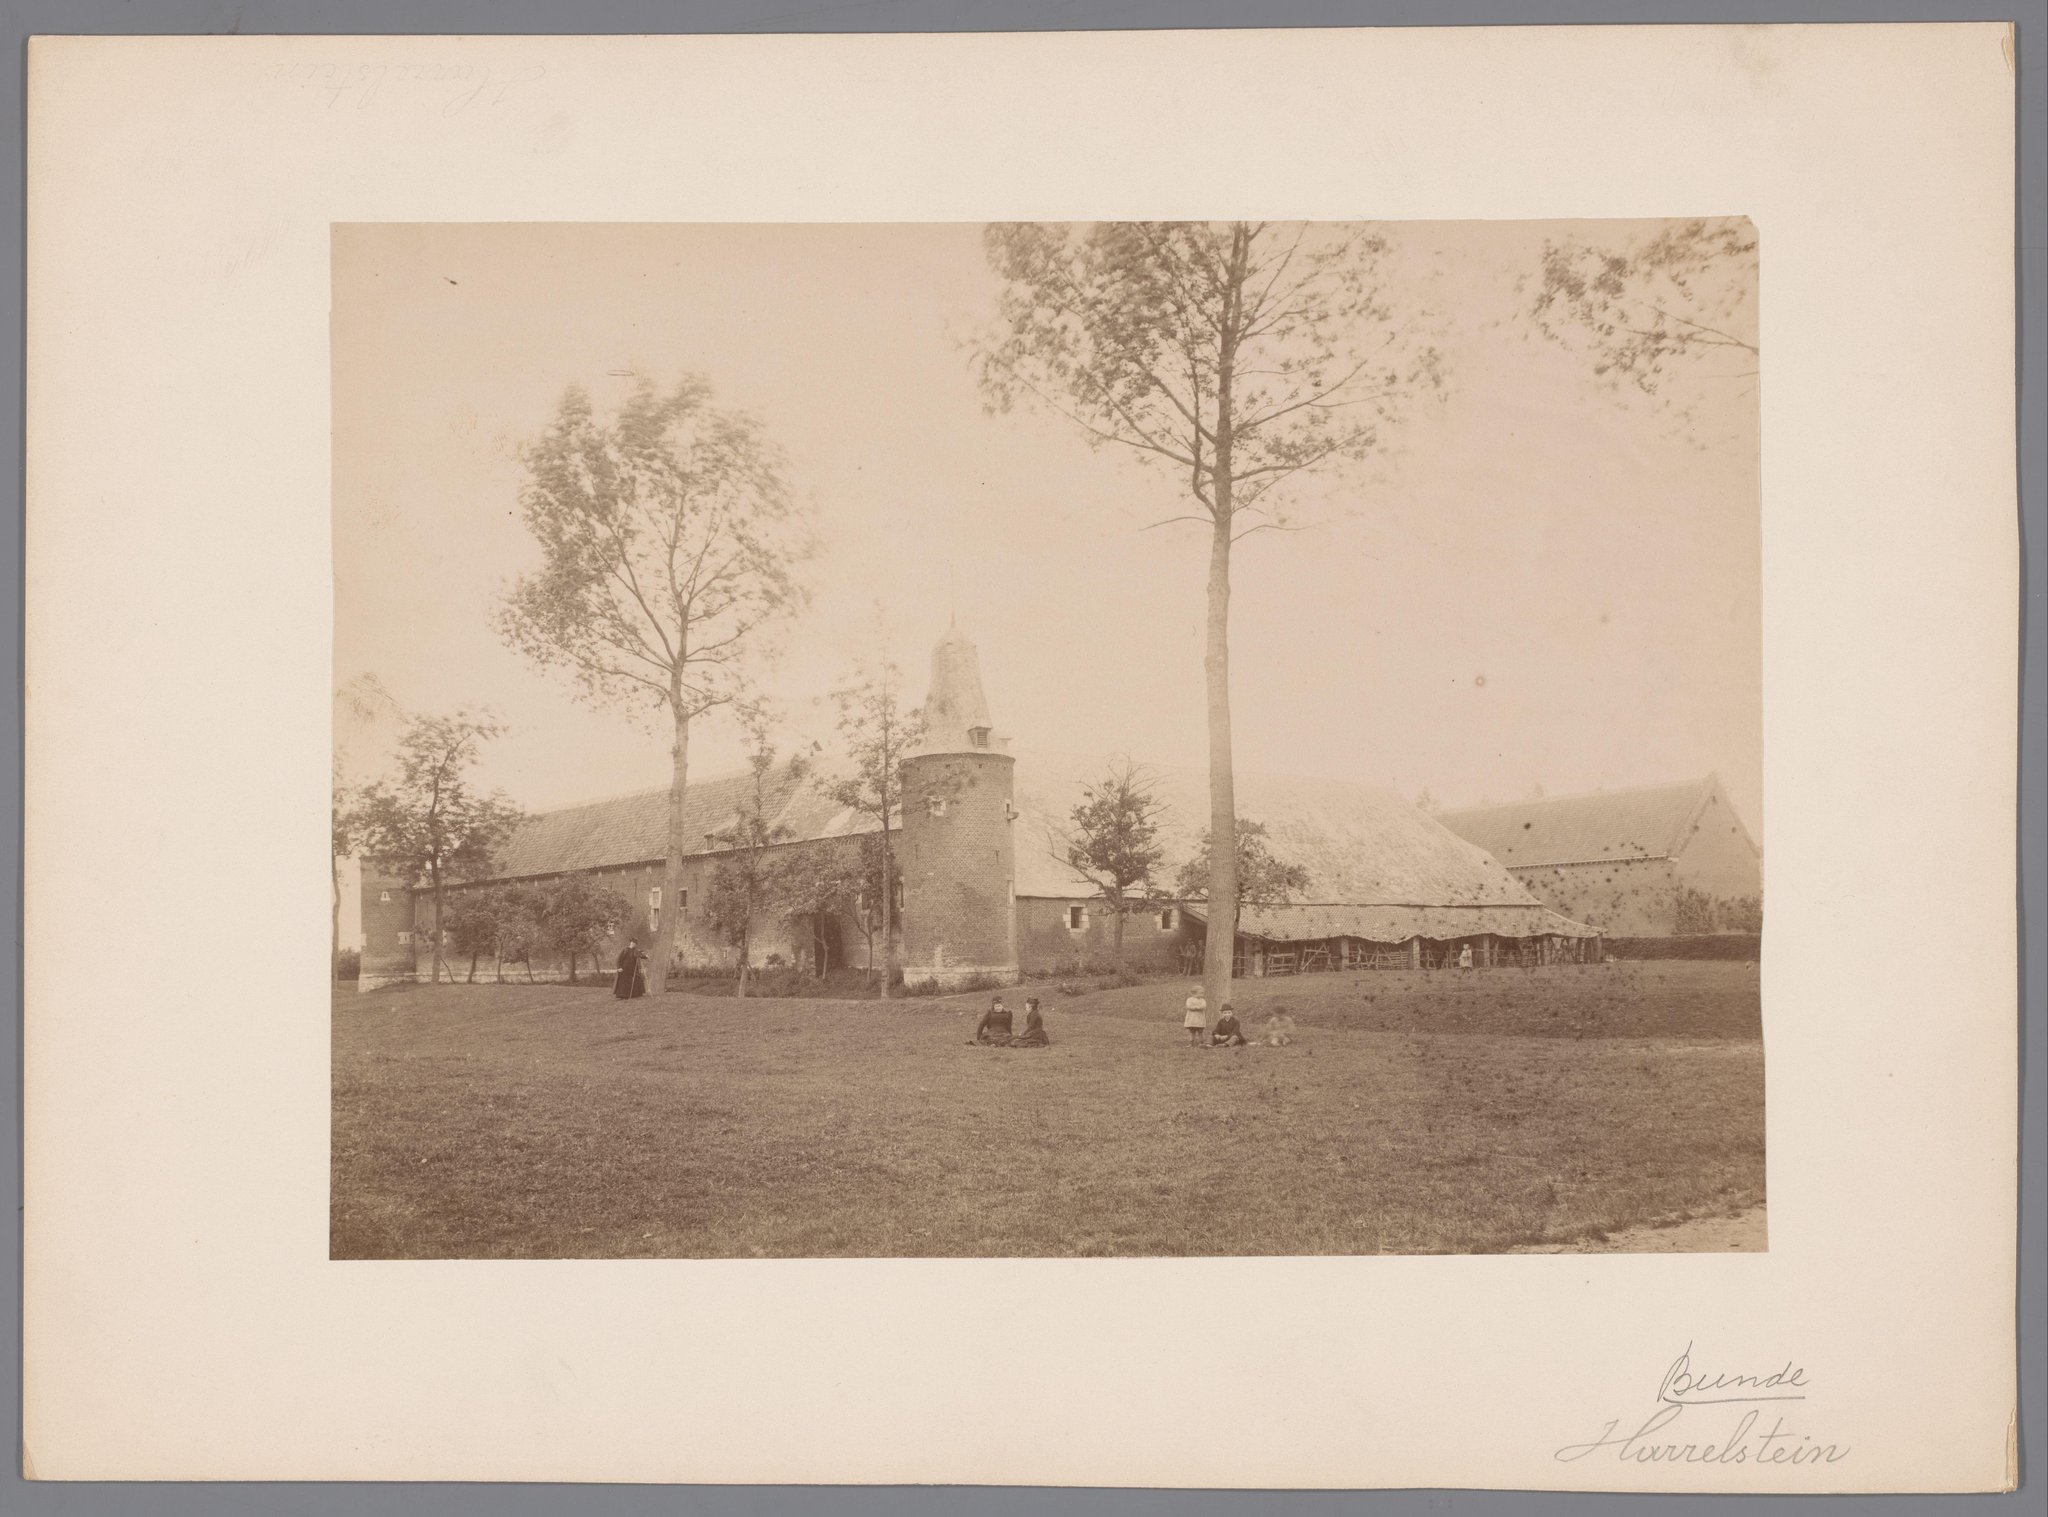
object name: photograph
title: Boerderij Harrelstein te Bunde, met zittende figuren op de voorgrond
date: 1893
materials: cardboard, photographic support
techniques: albumen print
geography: bunde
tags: taking photographs - cc - out of doors, farm or solitary house in landscape (+ city(-scape) with figures, staffage)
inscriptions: annotation: ‘Boerderij Harrelstein / te / Bunde bij Maastricht / Mei 1893’, annotation: ‘Bunde / Harrelstein’